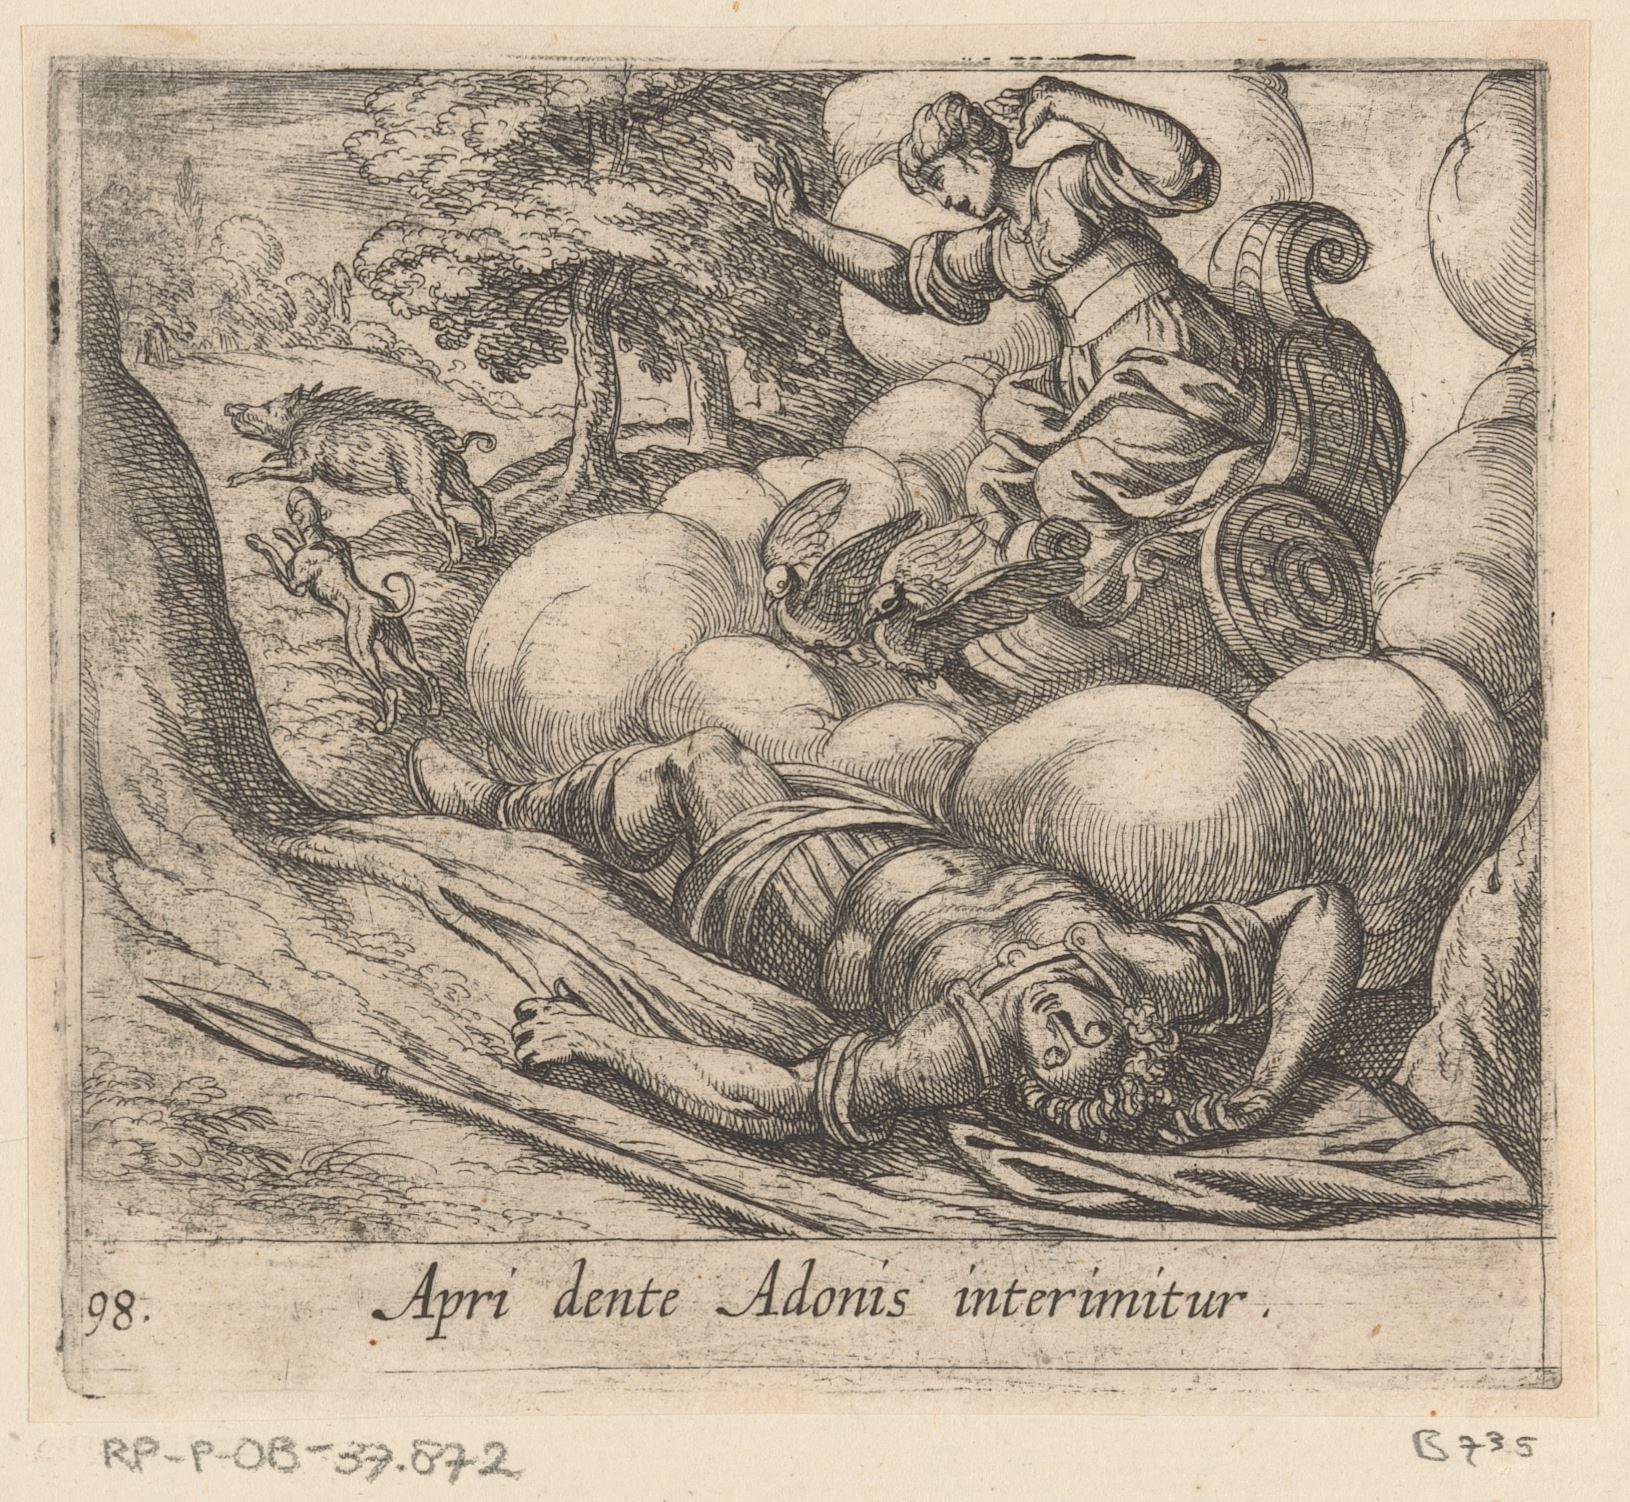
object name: print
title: Metamorphoseon sive transformationum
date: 1606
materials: paper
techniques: etching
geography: antwerp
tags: adonis' blood changed into an anemone or a rose: when adonis is slain by a boar, venus changes his blood into an anemone or a rose (ovid, metamorphoses x 735)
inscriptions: collector's mark: Lugt 240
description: Het dode lichaam van Adonis ligt op de grond. Venus, op een wagen die wordt getrokken door twee duiven, transformeert zijn bloed (in een bloem). Titel in het Latijn in ondermarge.